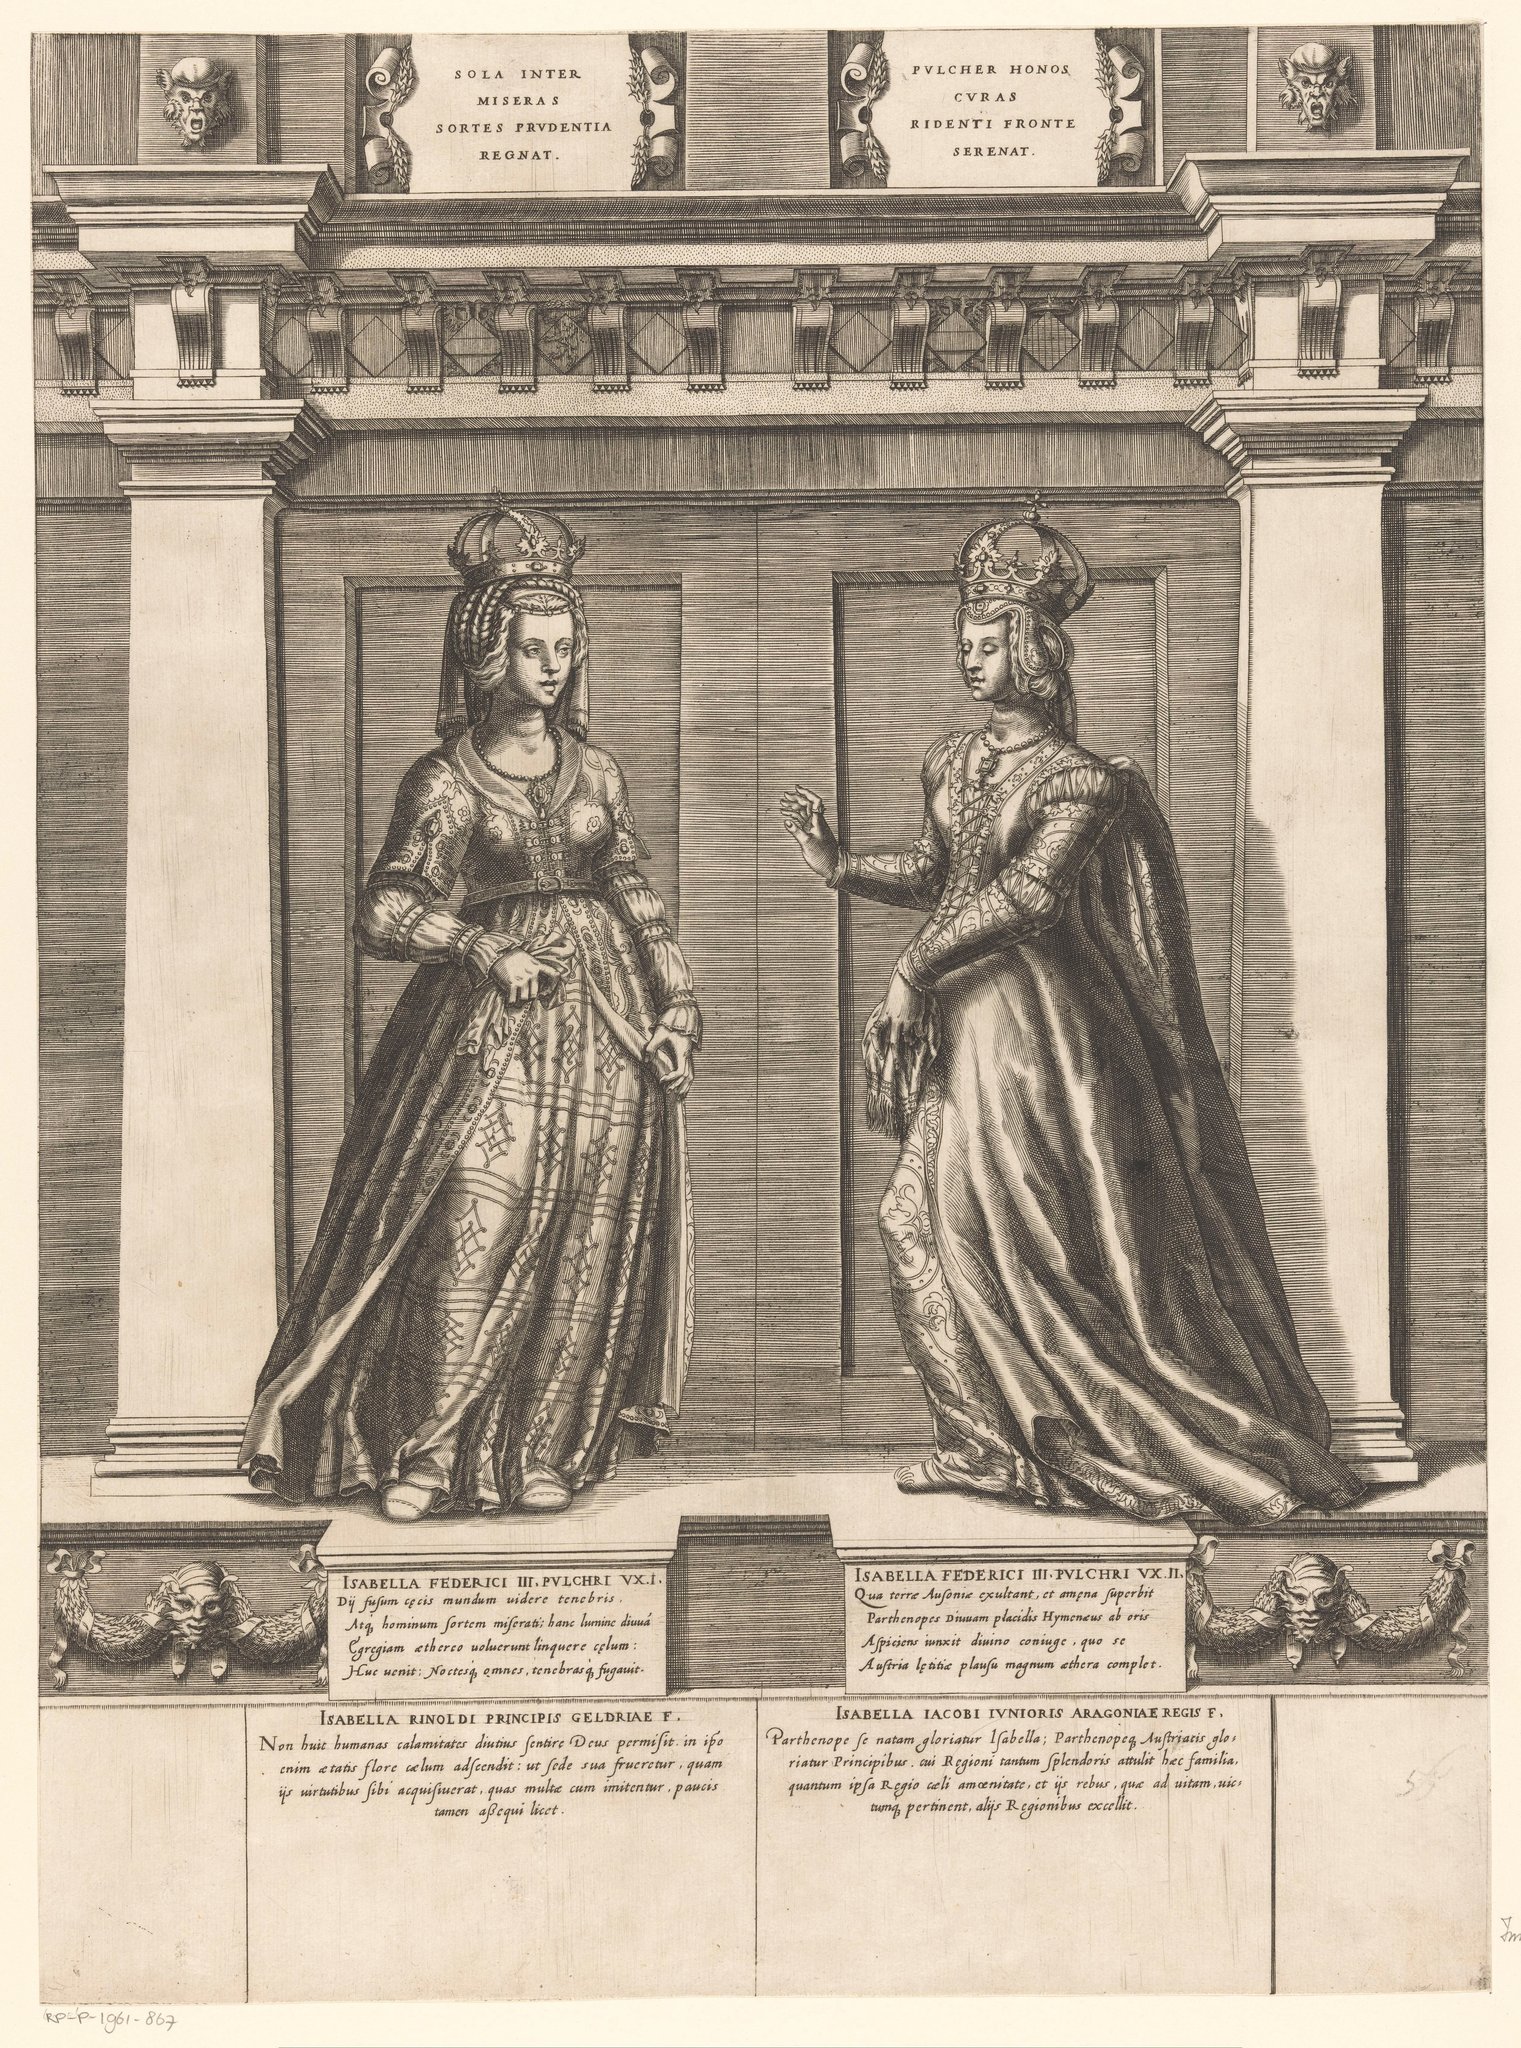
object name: print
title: Dubbelportret van Isabella van Gelderen en Isabella van Aragón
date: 1569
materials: paper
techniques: engraving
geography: italy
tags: historical persons - bb - woman, ruler, sovereign - bb - female ruler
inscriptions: collector's mark: Lugt 2228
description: Deze prent maakt deel uit van een reeks van 58 prenten. Het meerendeel van de prenten bevat portretten van 74 leden van het Oostenrijkse Huis, naar tekeningen door Francesco Terzio, die deels getekend zijn naar de 28 levensgrote bronzen beelden die rond de cenotaaf van Maximiliaan I in de Hofkirche te Innsbruck staan.